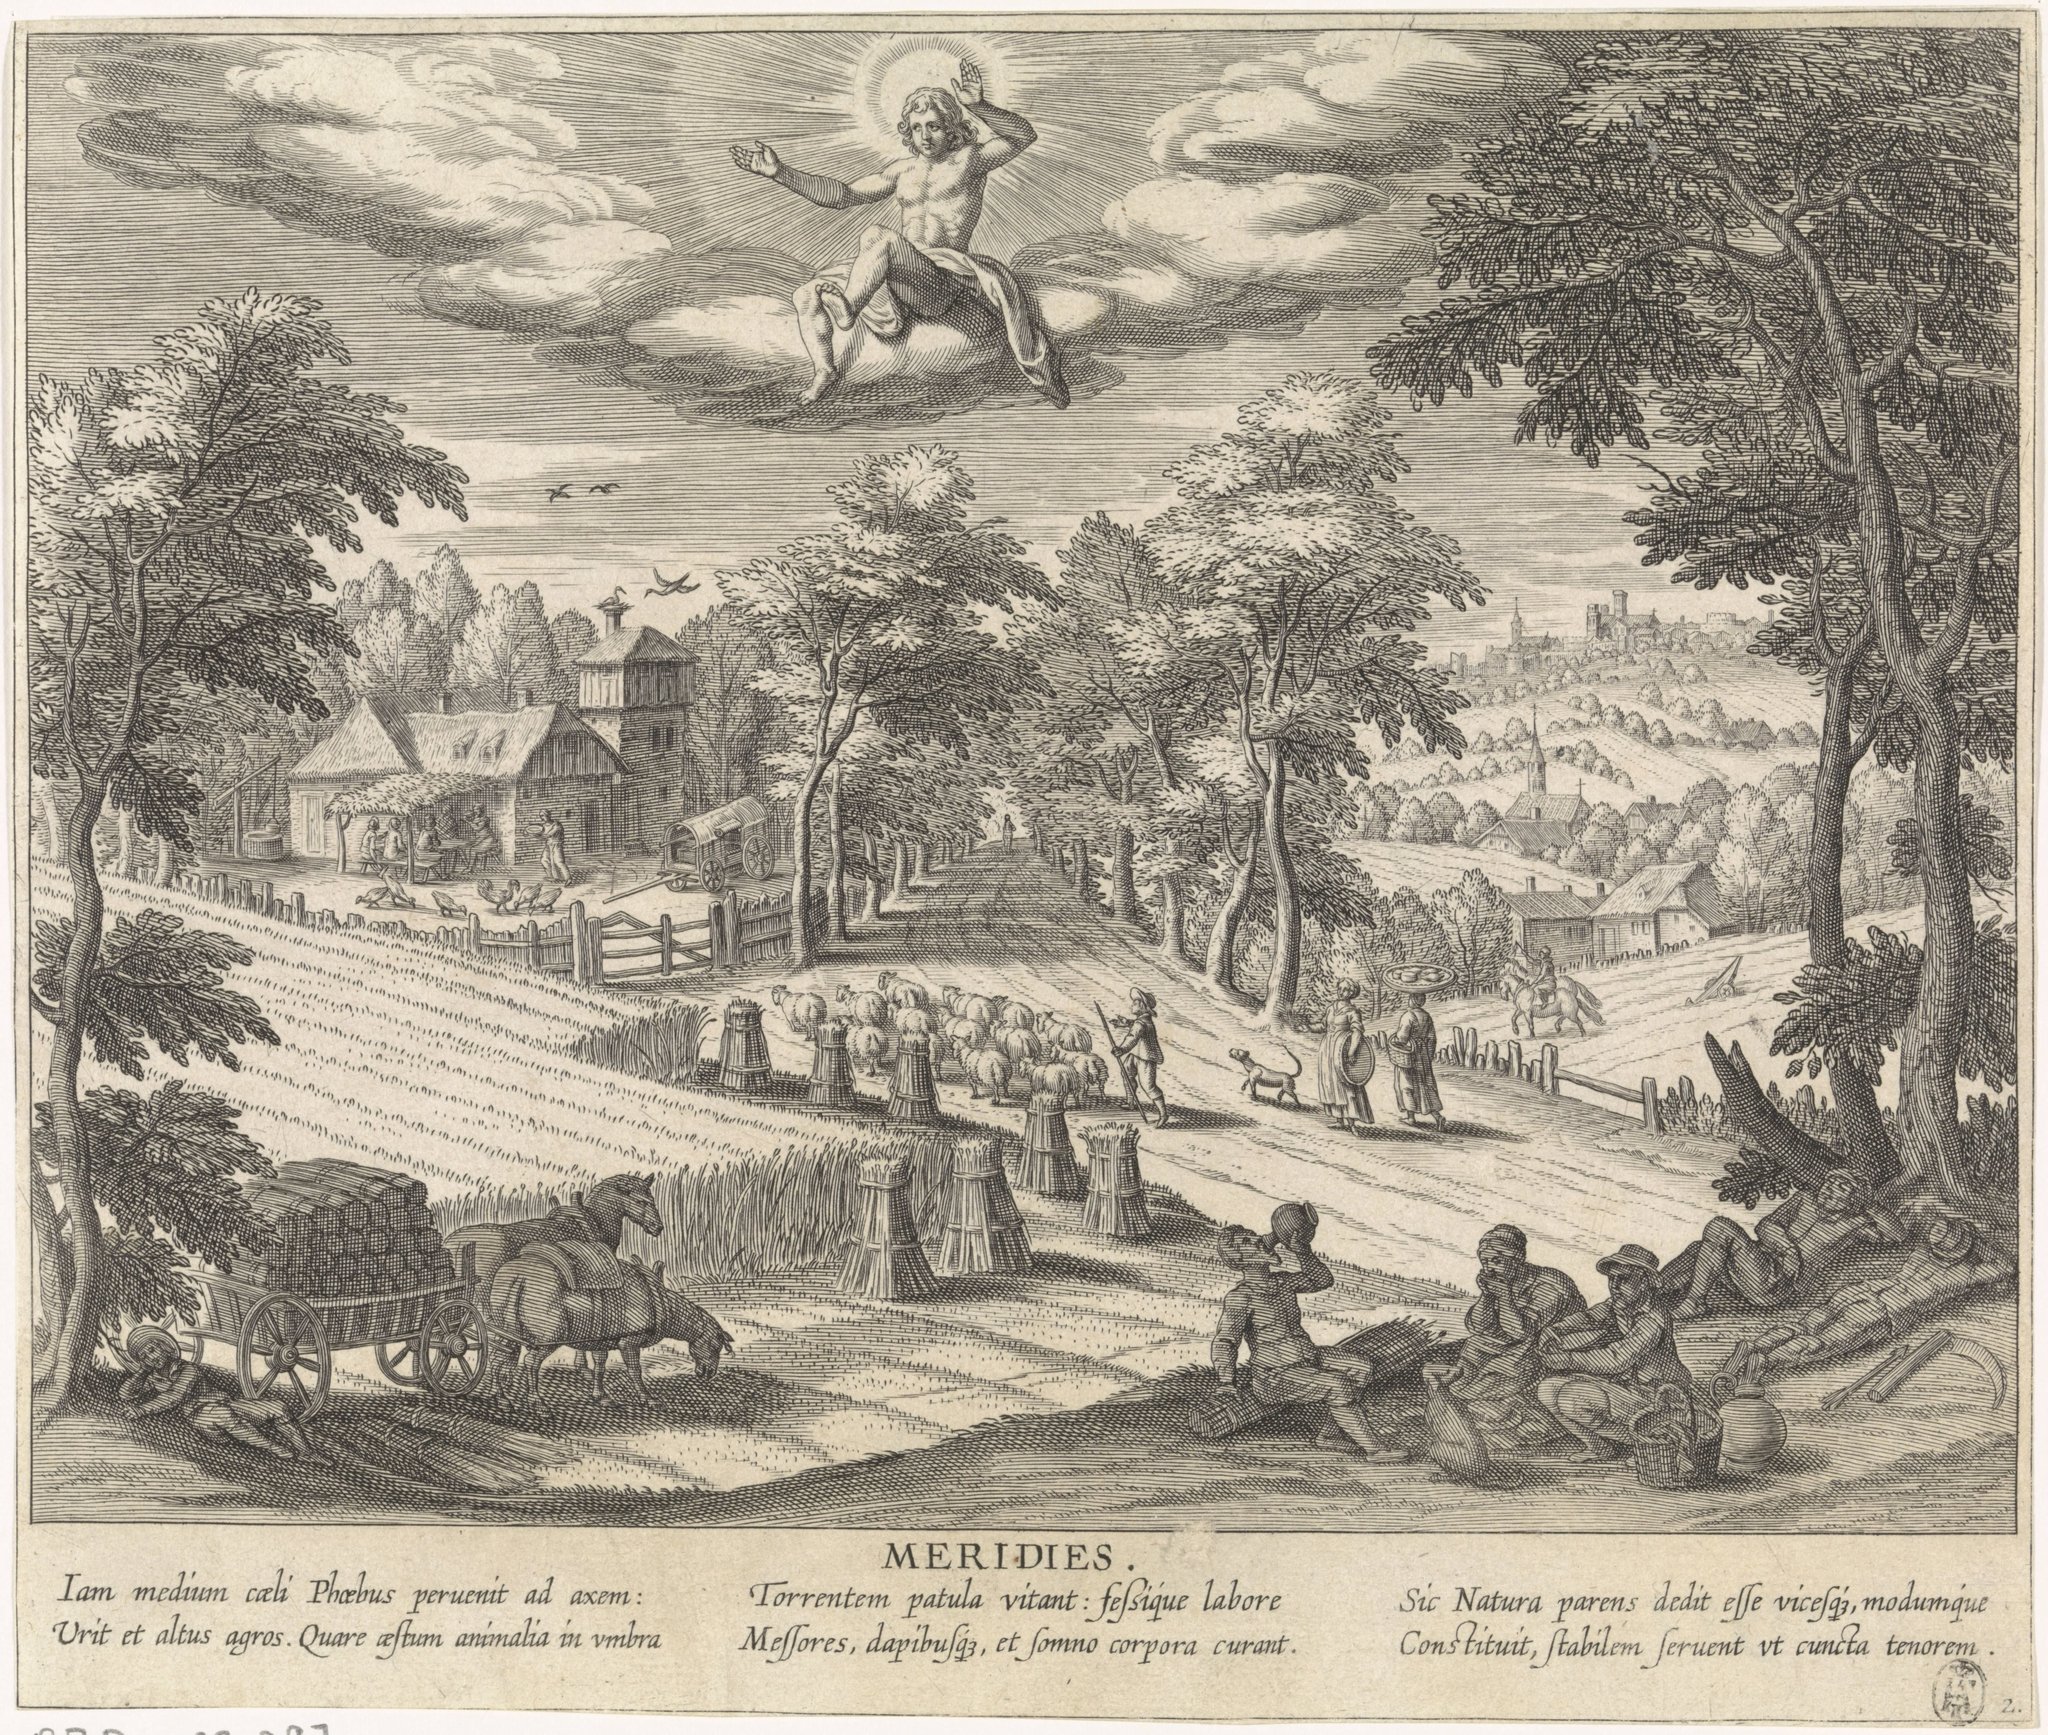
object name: print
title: Vier dagdelen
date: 1590-1637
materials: paper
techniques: engraving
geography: antwerp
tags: afternoon ~ landscape (sometimes titled 'meridies'), personification of the afternoon, 'meridies'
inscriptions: collector's mark: Lugt 2228, collector's mark: Lugt 972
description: Landschap met de personificatie van Meridiës. Op een pad een herder met zijn kudde schapen. Op de voorgrond rustende figuren. In de marge een zesregelig onderschrift, in drie kolommen, in het Latijn. Tweede prent uit een serie met de vier dagdelen.